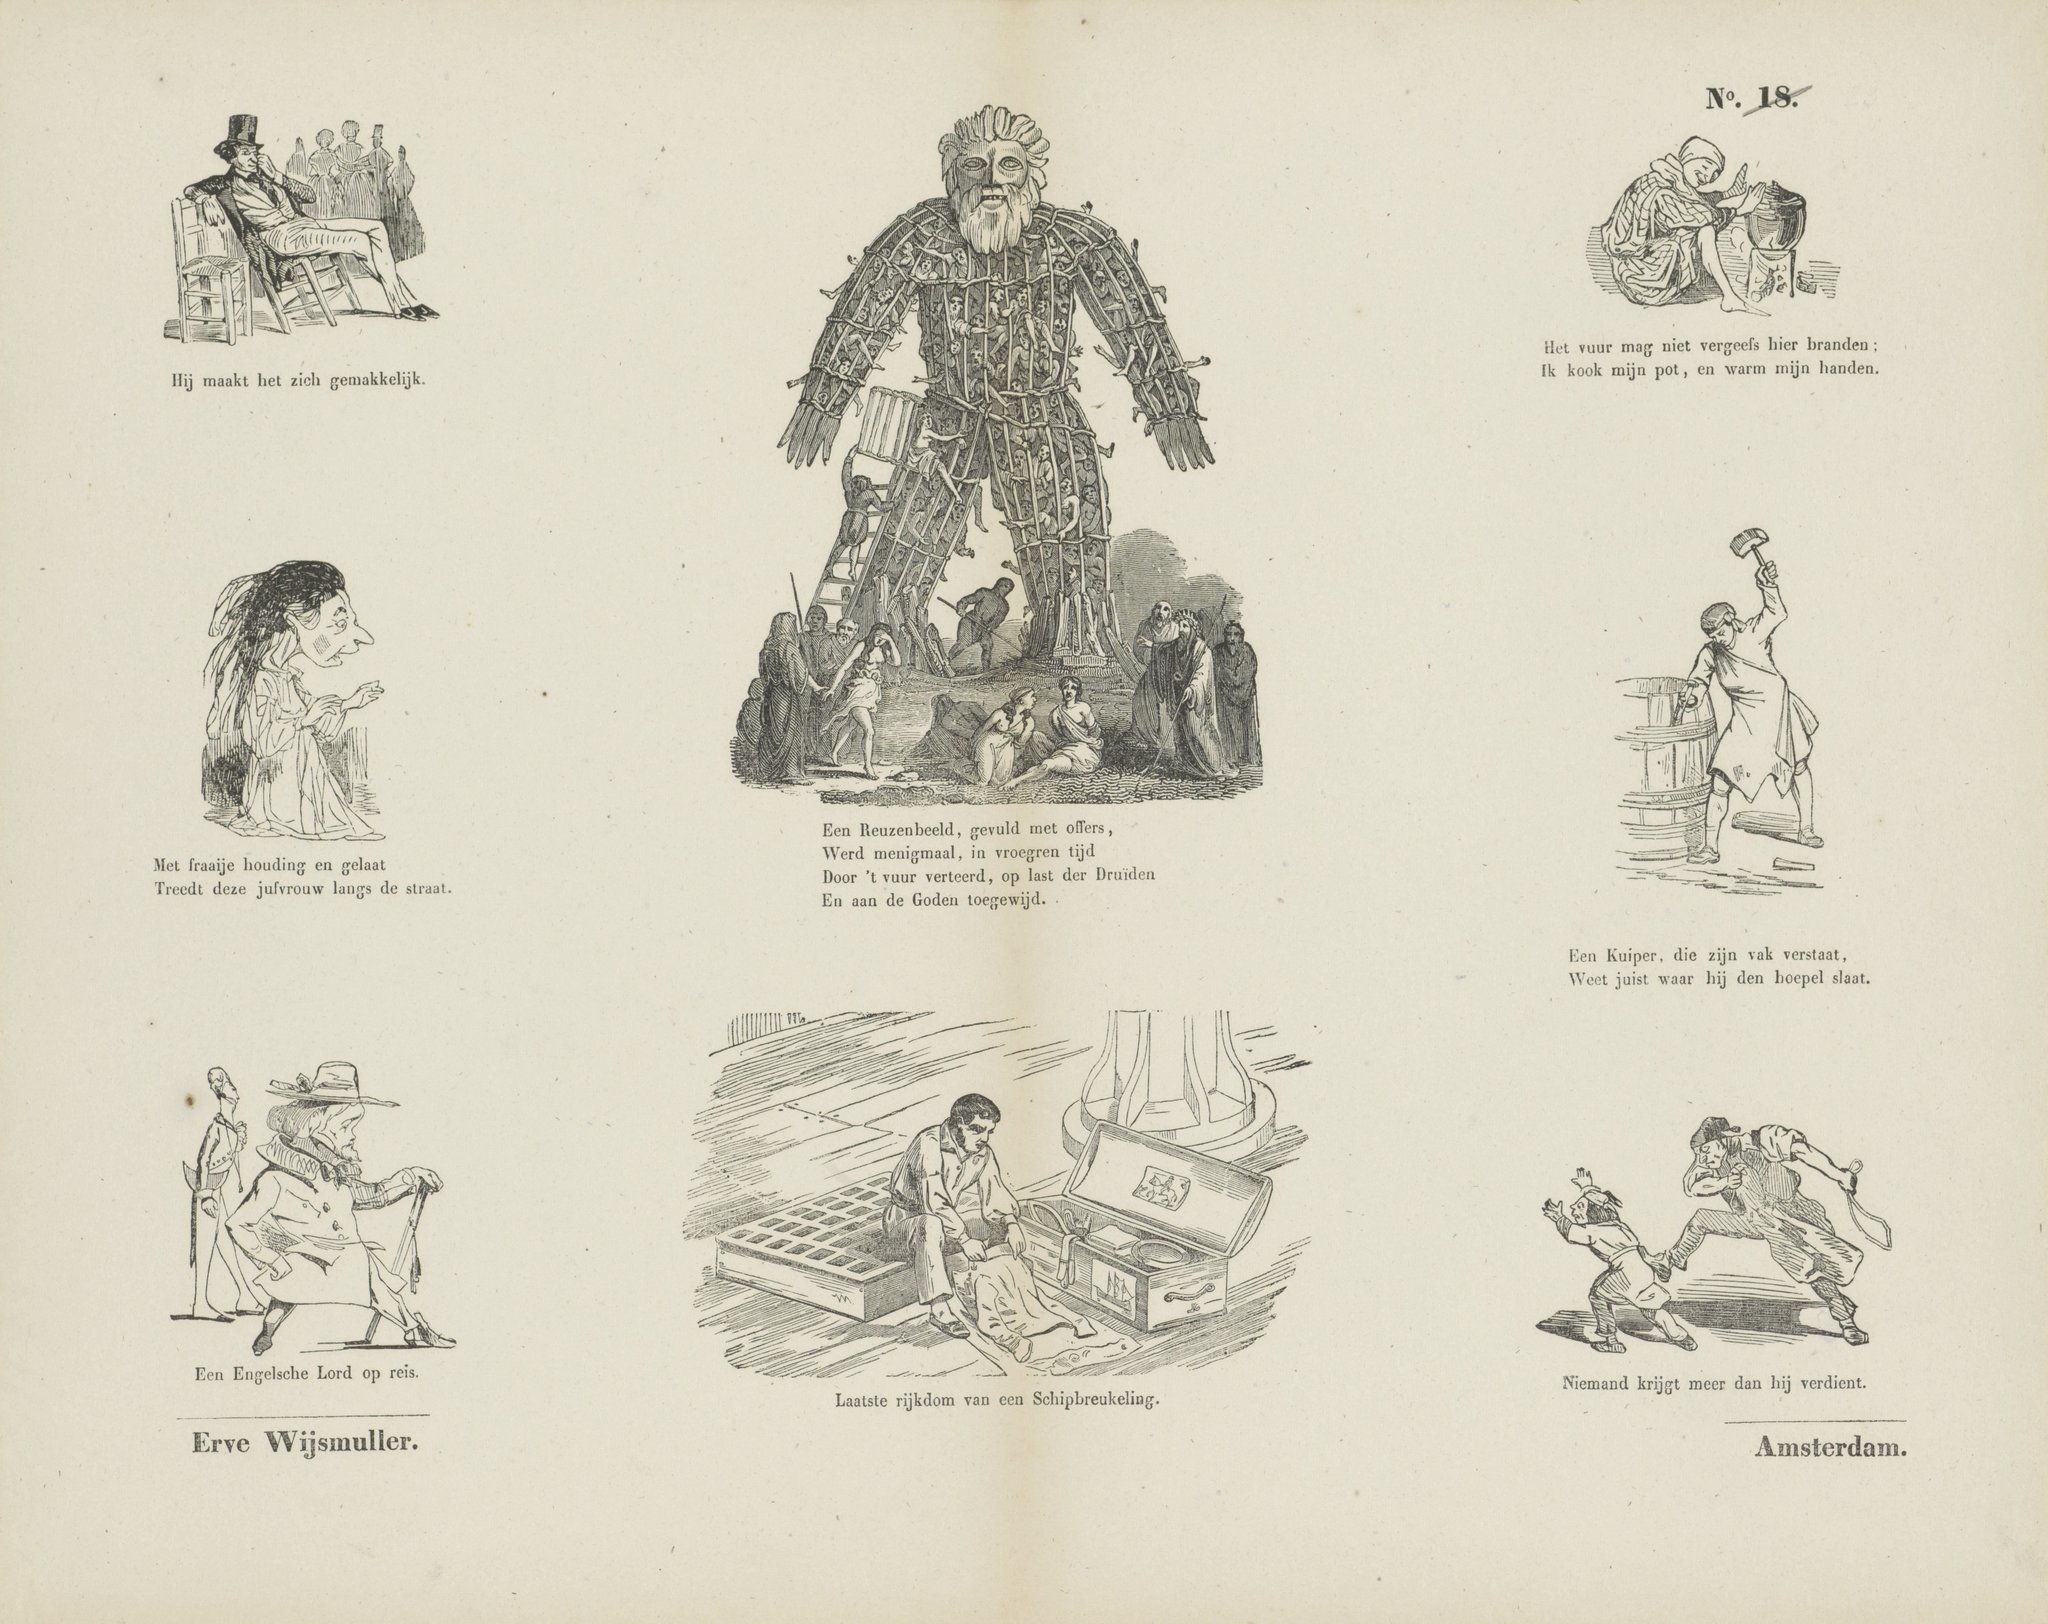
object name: print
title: Verschillende voorstellingen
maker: Anonymous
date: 1828-1913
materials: paper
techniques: letterpress printing, line block, engraving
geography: amsterdam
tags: human sacrifice ~ non-christian religions, characters (human types), travelling; tourism, crafts and industries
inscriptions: collector's mark: Lugt 2760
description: Blad met 8 voorstellingen van verschillende aard, waaronder een een reuzenbeeld gevuld met menselijke offers, een kuiper aan het werk en een Engelse Lord op reis. Onder elke afbeelding een onderschrift. Onder de eerste afbeelding het onderschrift: Hij maakt het zich gemakkelijk. Genummerd rechtsboven: No. 18 (doorgestreept en verbeterd in 23, in potlood).